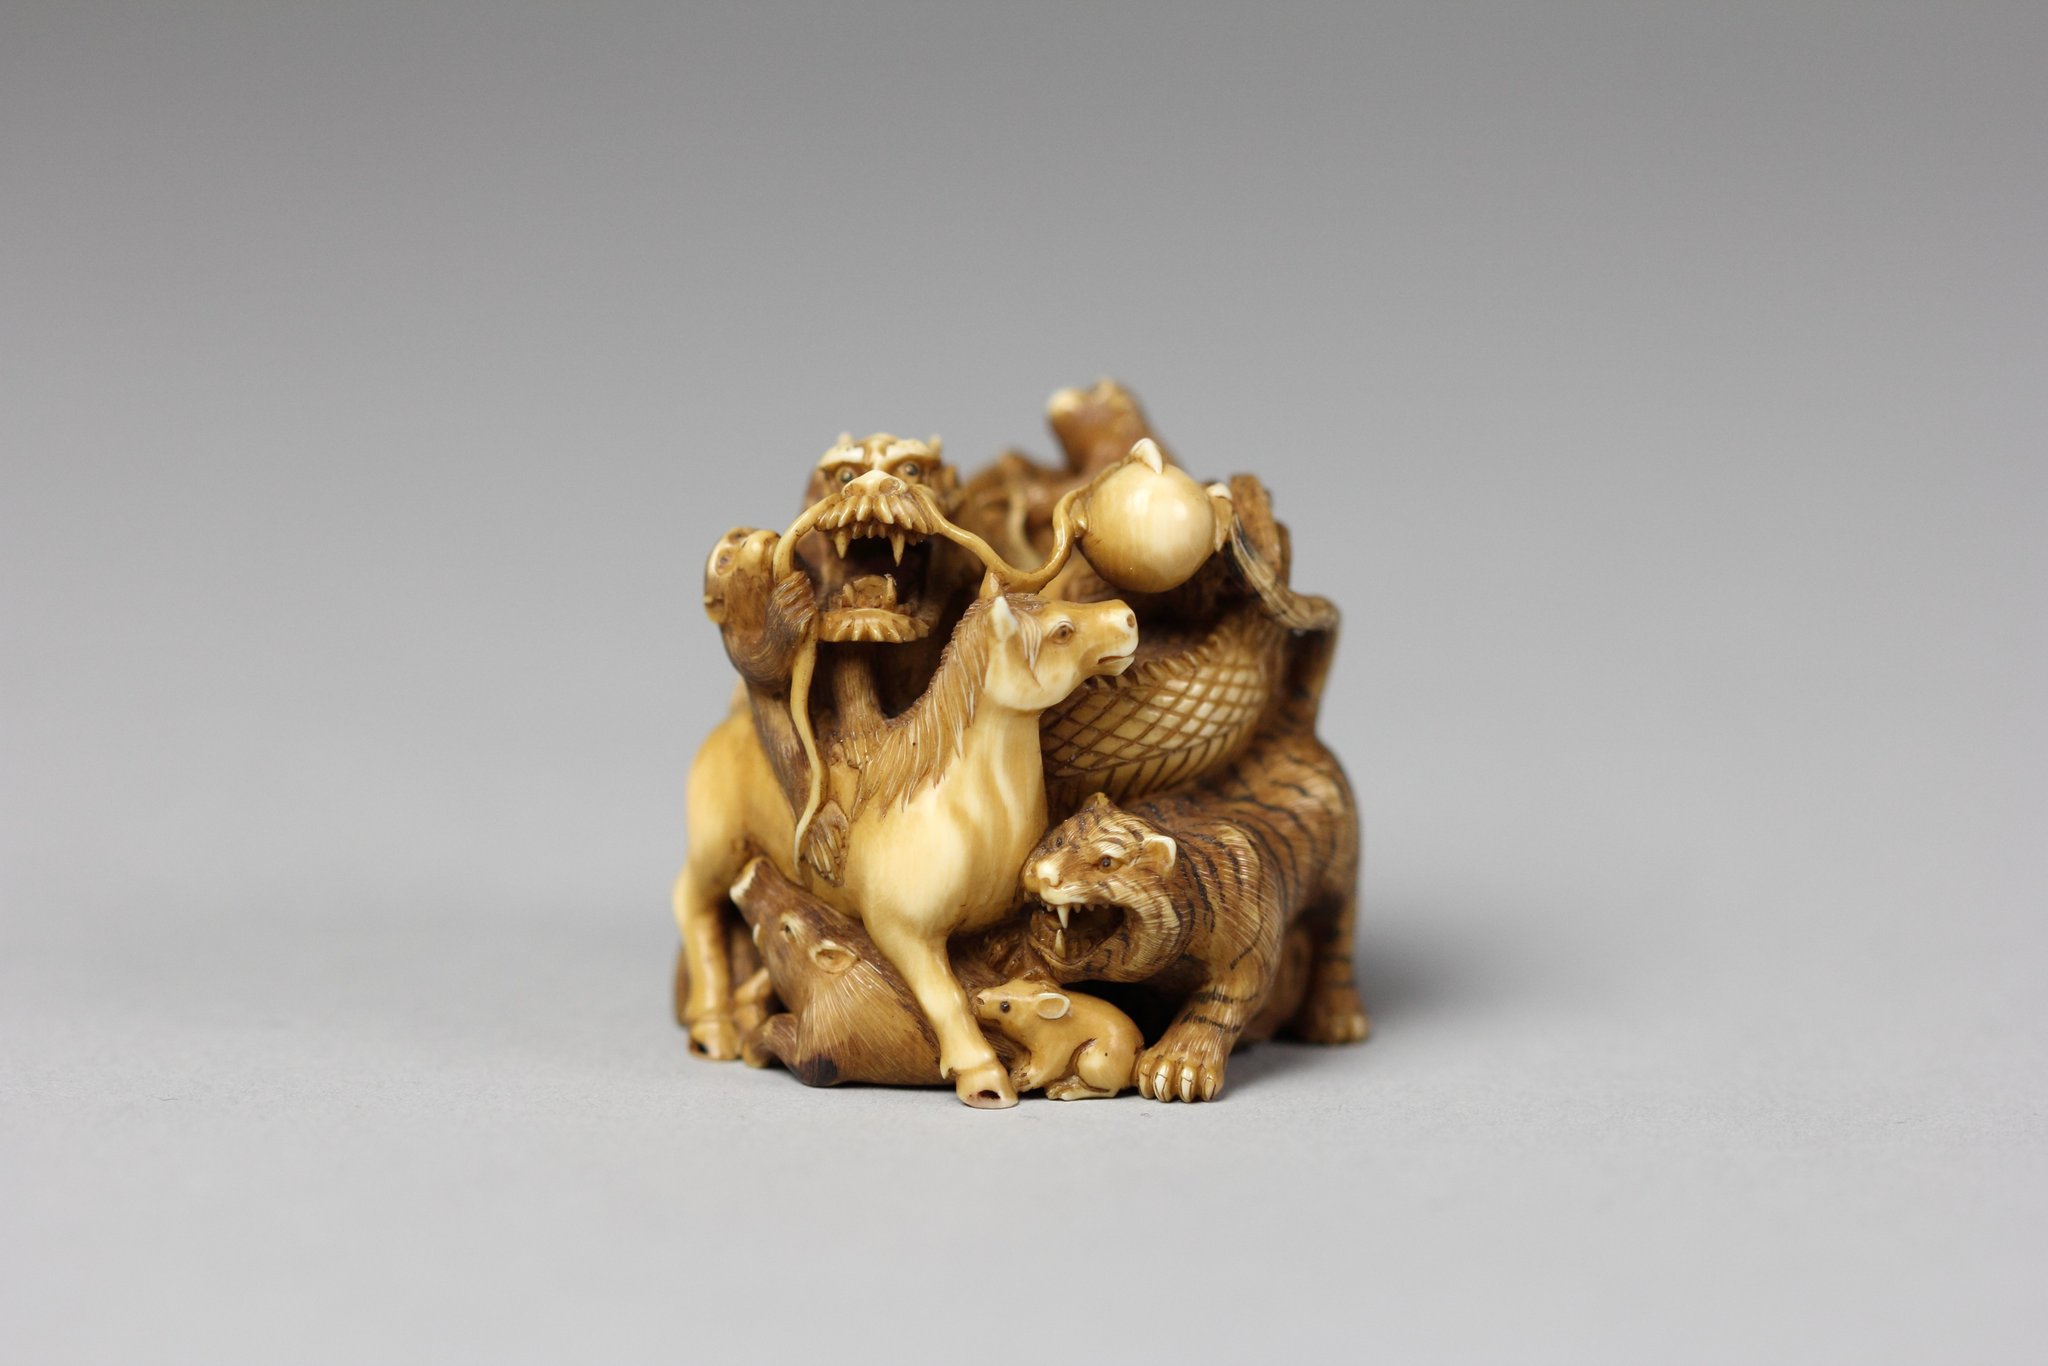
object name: netsuke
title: Netsuke of Group of Animals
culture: japanese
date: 1701-1800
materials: ivory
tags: dragons,roosters,boars,horses,mice,monkeys,rabbits